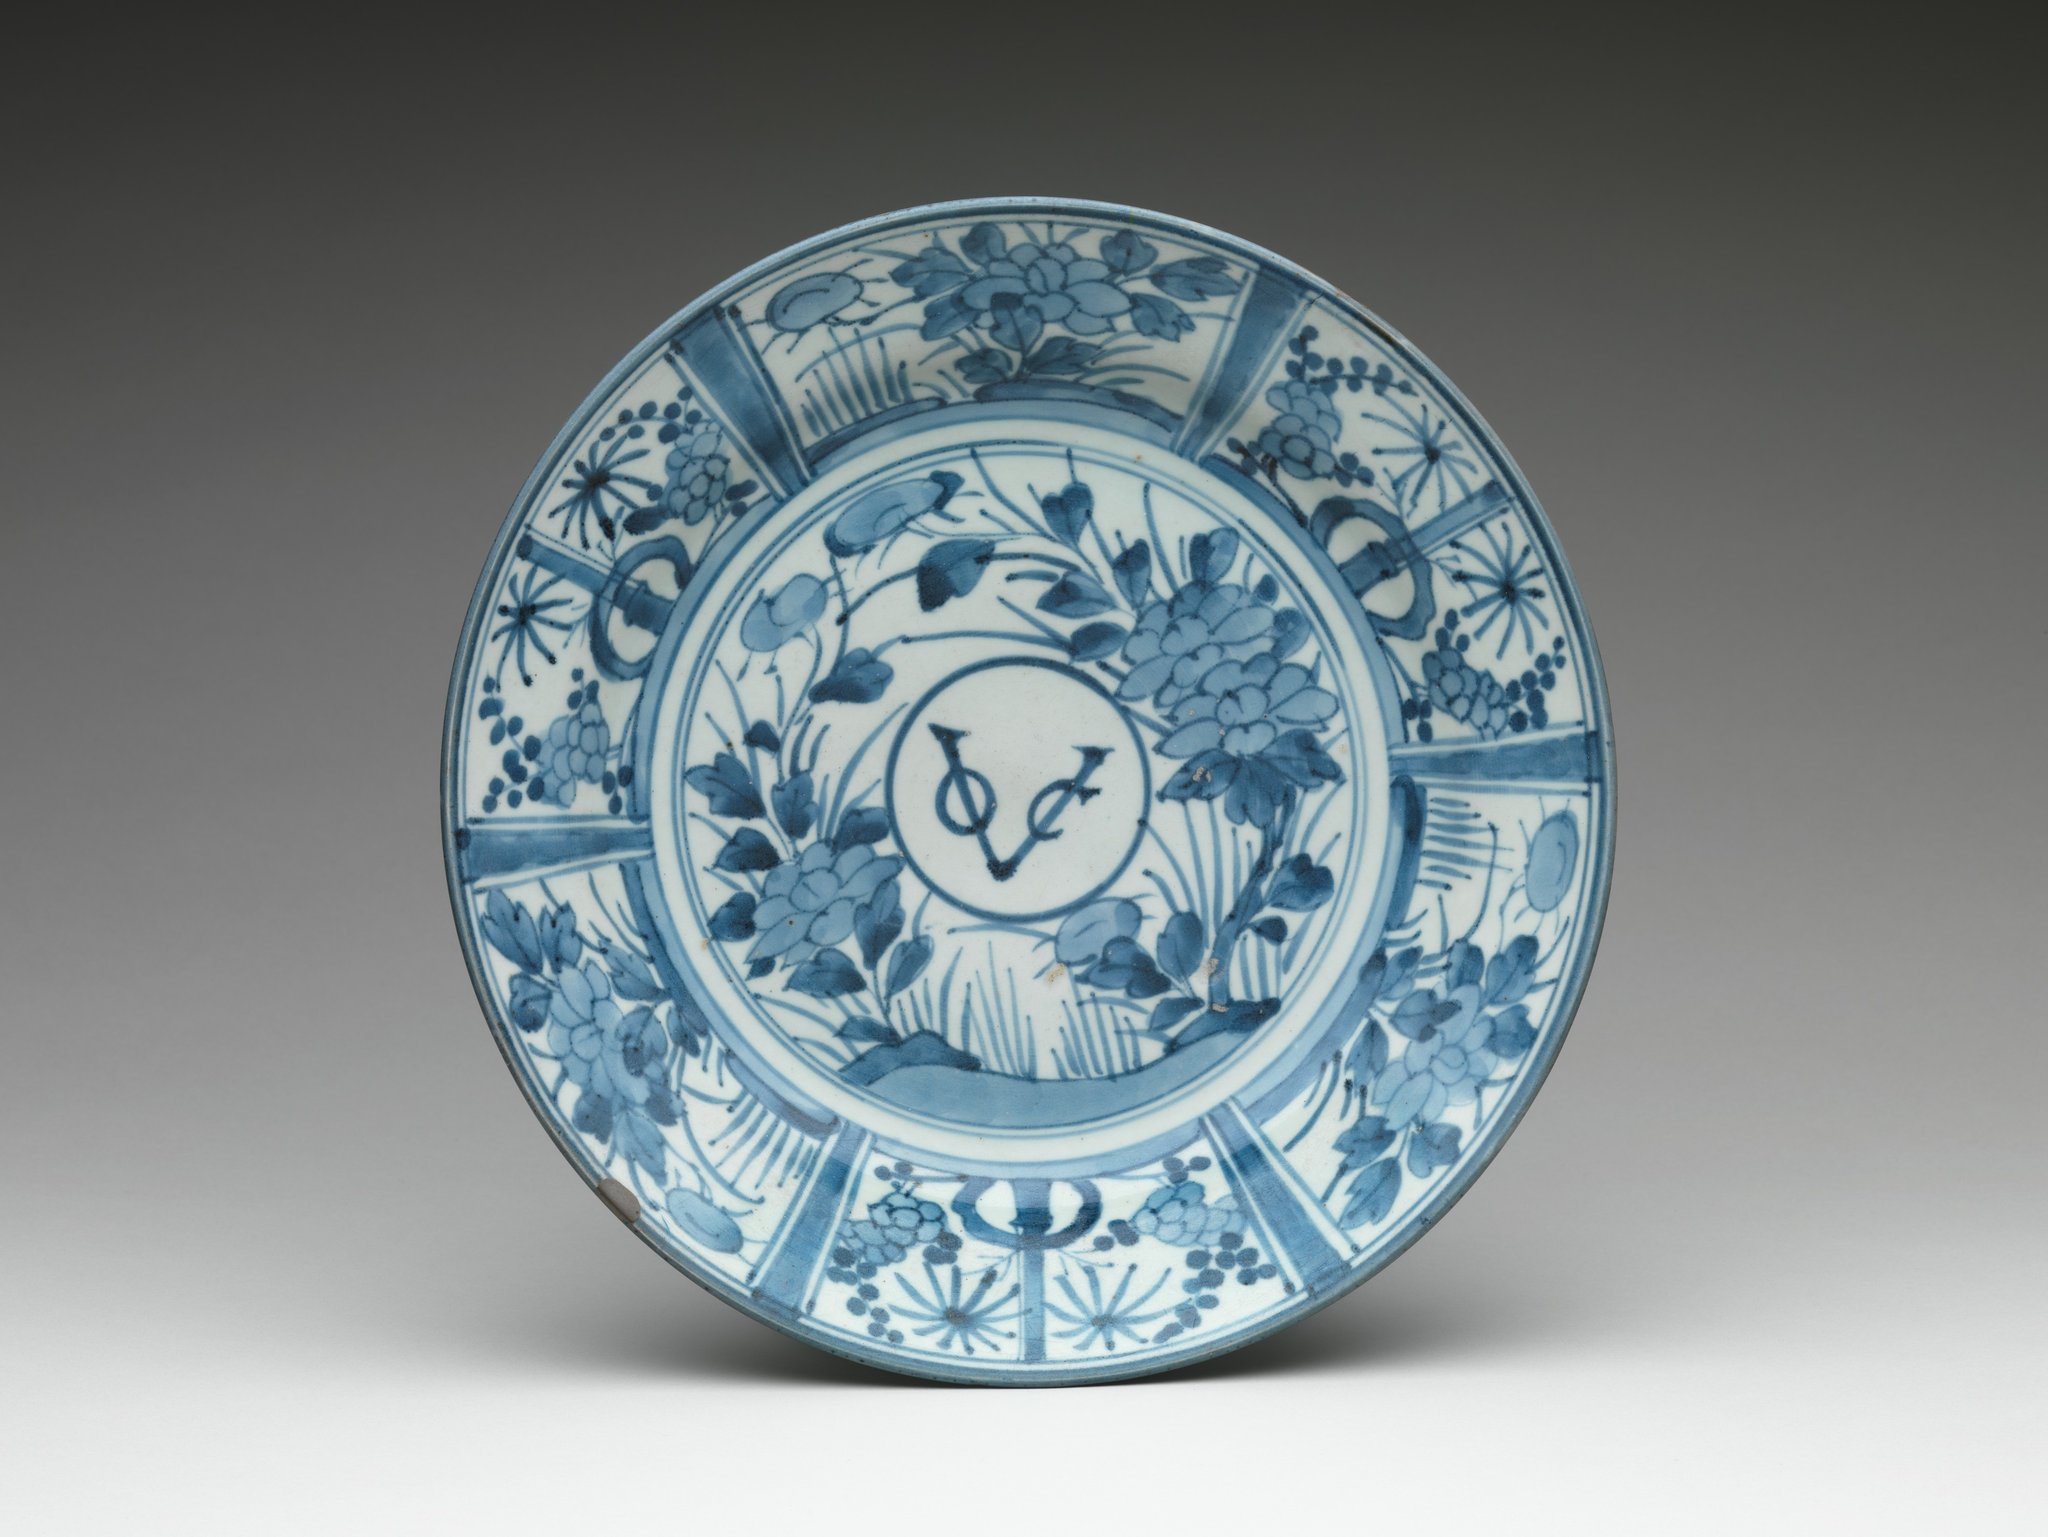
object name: plate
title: Plate with Monogram of the Dutch East India Company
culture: japanese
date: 1660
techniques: underglaze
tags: flowers